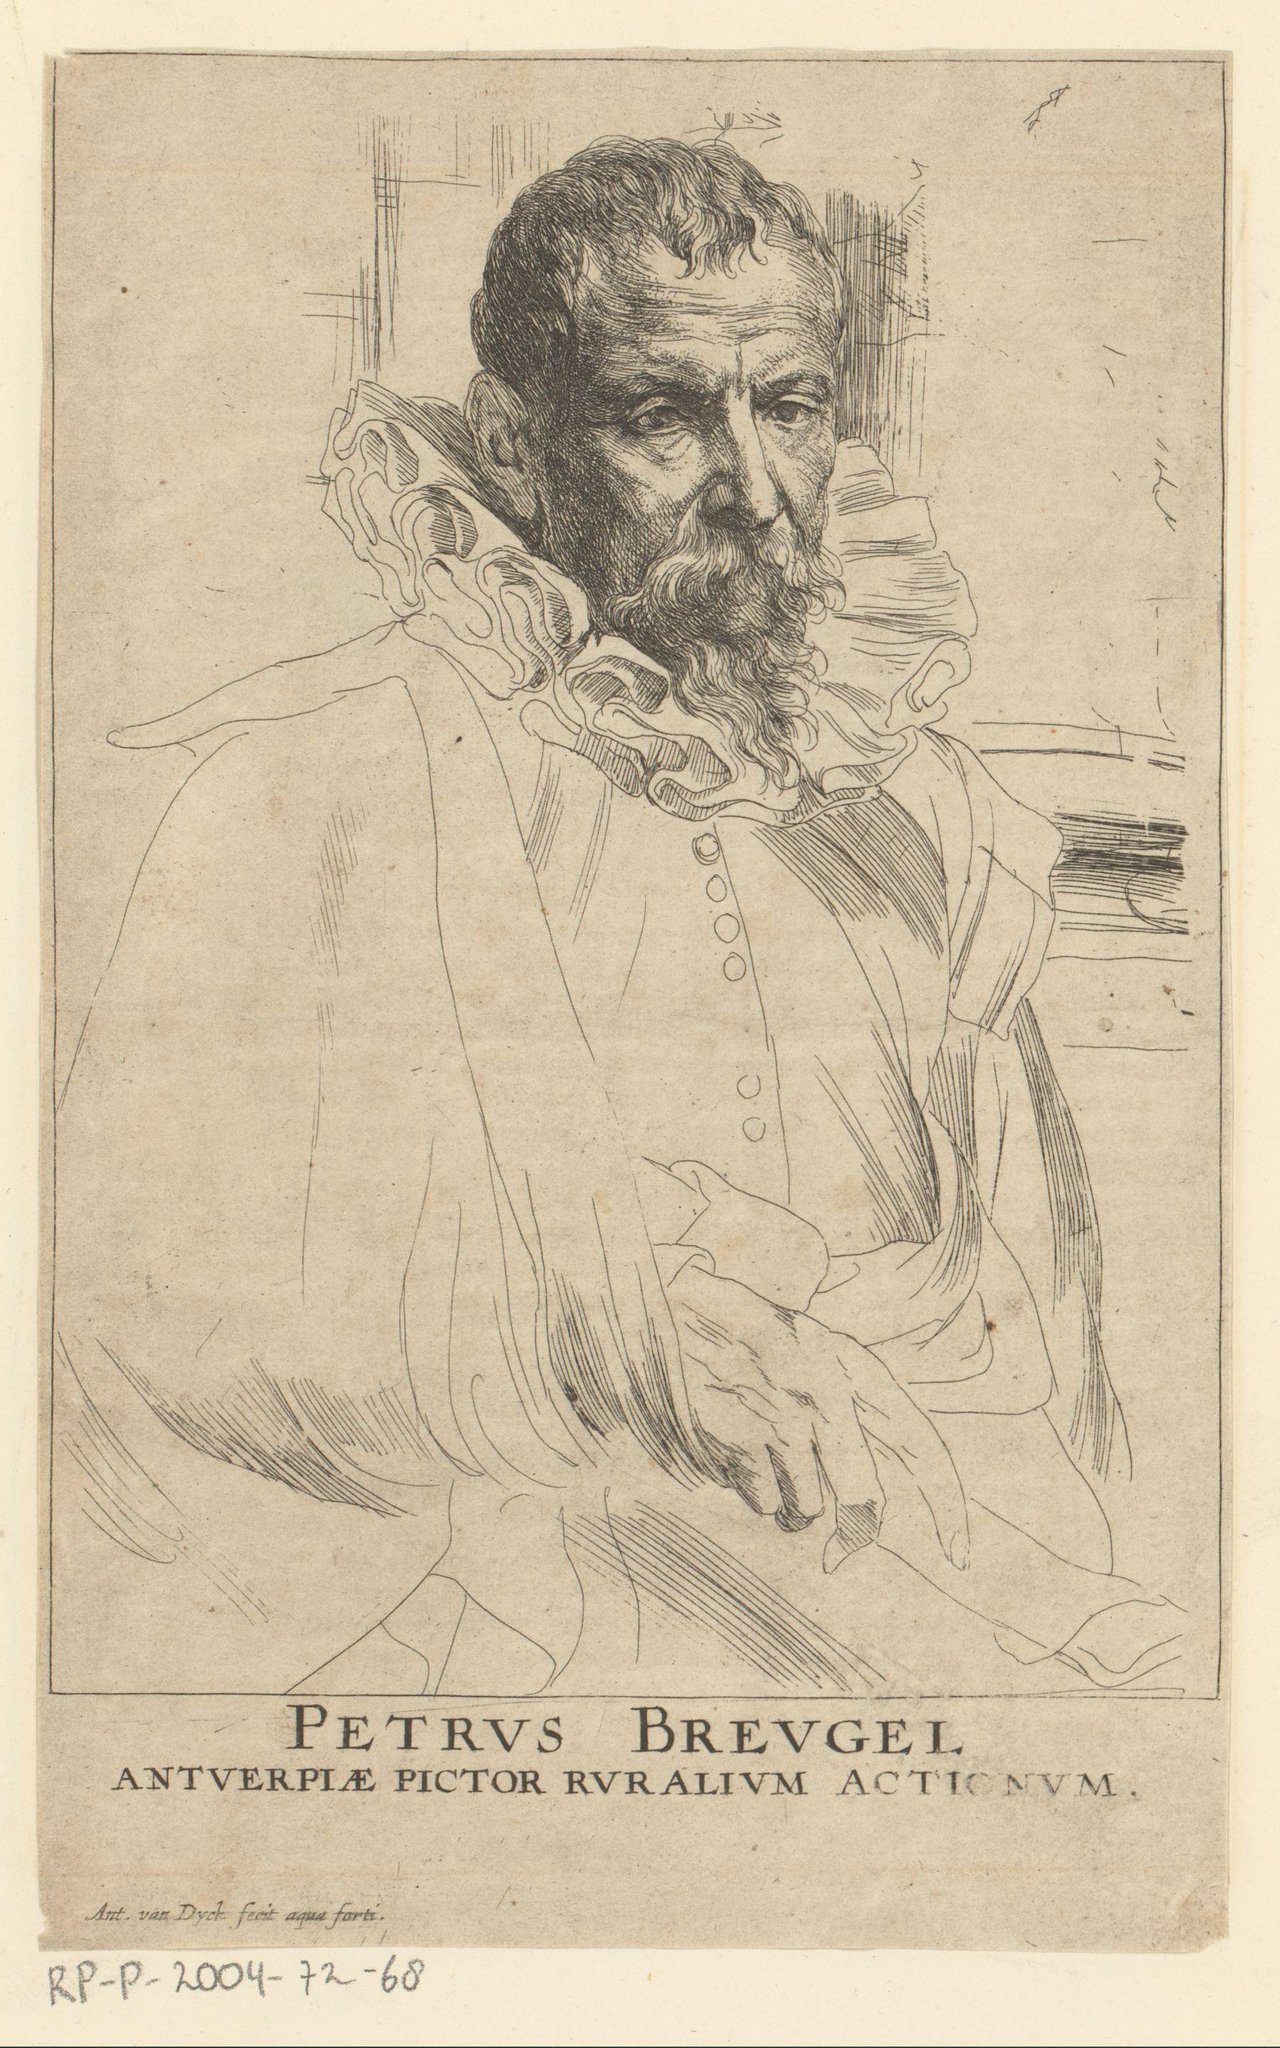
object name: album leaf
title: Petrus Breugel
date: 1645-1646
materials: paper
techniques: etching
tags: brussels, draughtsman, pieter brueghel (ii), historical persons, portrait, self-portrait of painter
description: Prent uit: Iconographie ou Vies des Hommes Illustres du XVII. Siecle (...). 2 dln. Amsterdam: Johann Caspar Arkstee, Leipzig: Henricus Merkus, 1759, dl. 2, p. 68. Prent is ontworpen voor de serie getiteld 'Iconographie' samengesteld door Anthony van Dyck en uitgegeven in 1645-1646. De samensteller heeft deze prent in het album geplakt als illustratie bij: Pilkington, Matthew en Johann Heinrich Füssli. A dictionary of painters, from the revival of the art to the present period. 4 dln. Londen: John Crowder, 1805, dl. 1, p. 87.